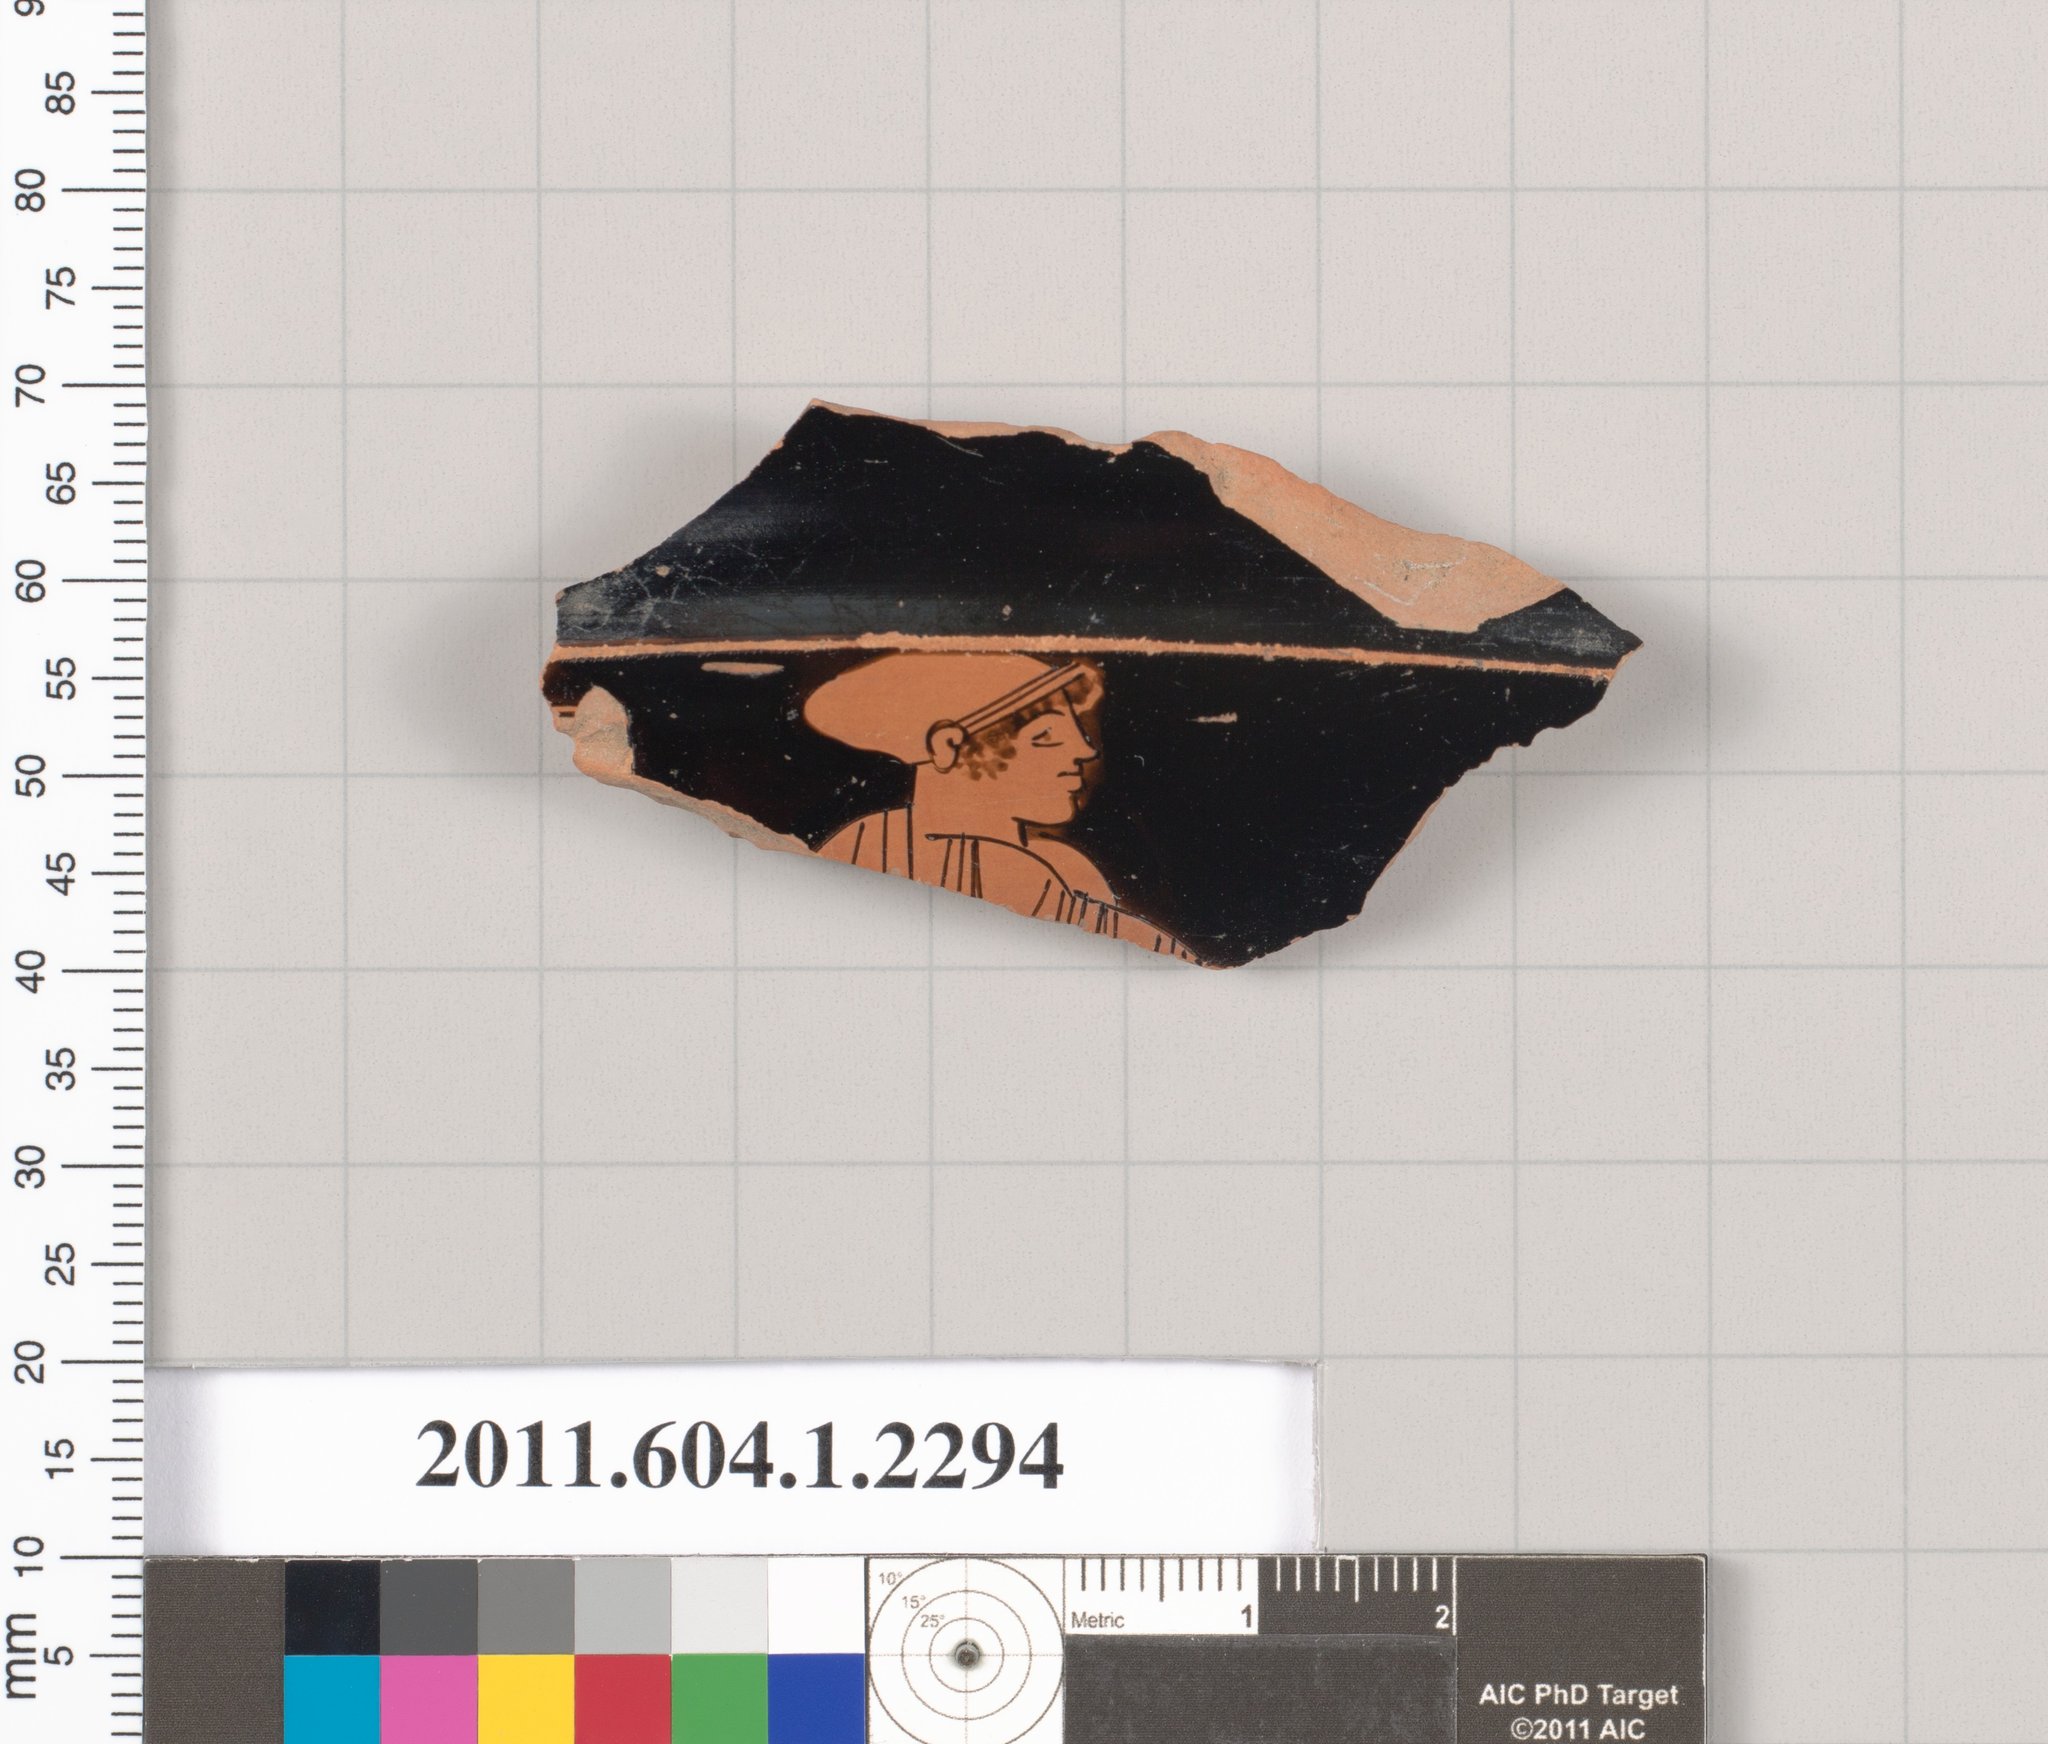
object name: kylix fragment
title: Terracotta fragment of a kylix (drinking cup)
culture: greek, attic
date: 475-451 BCE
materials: terracotta